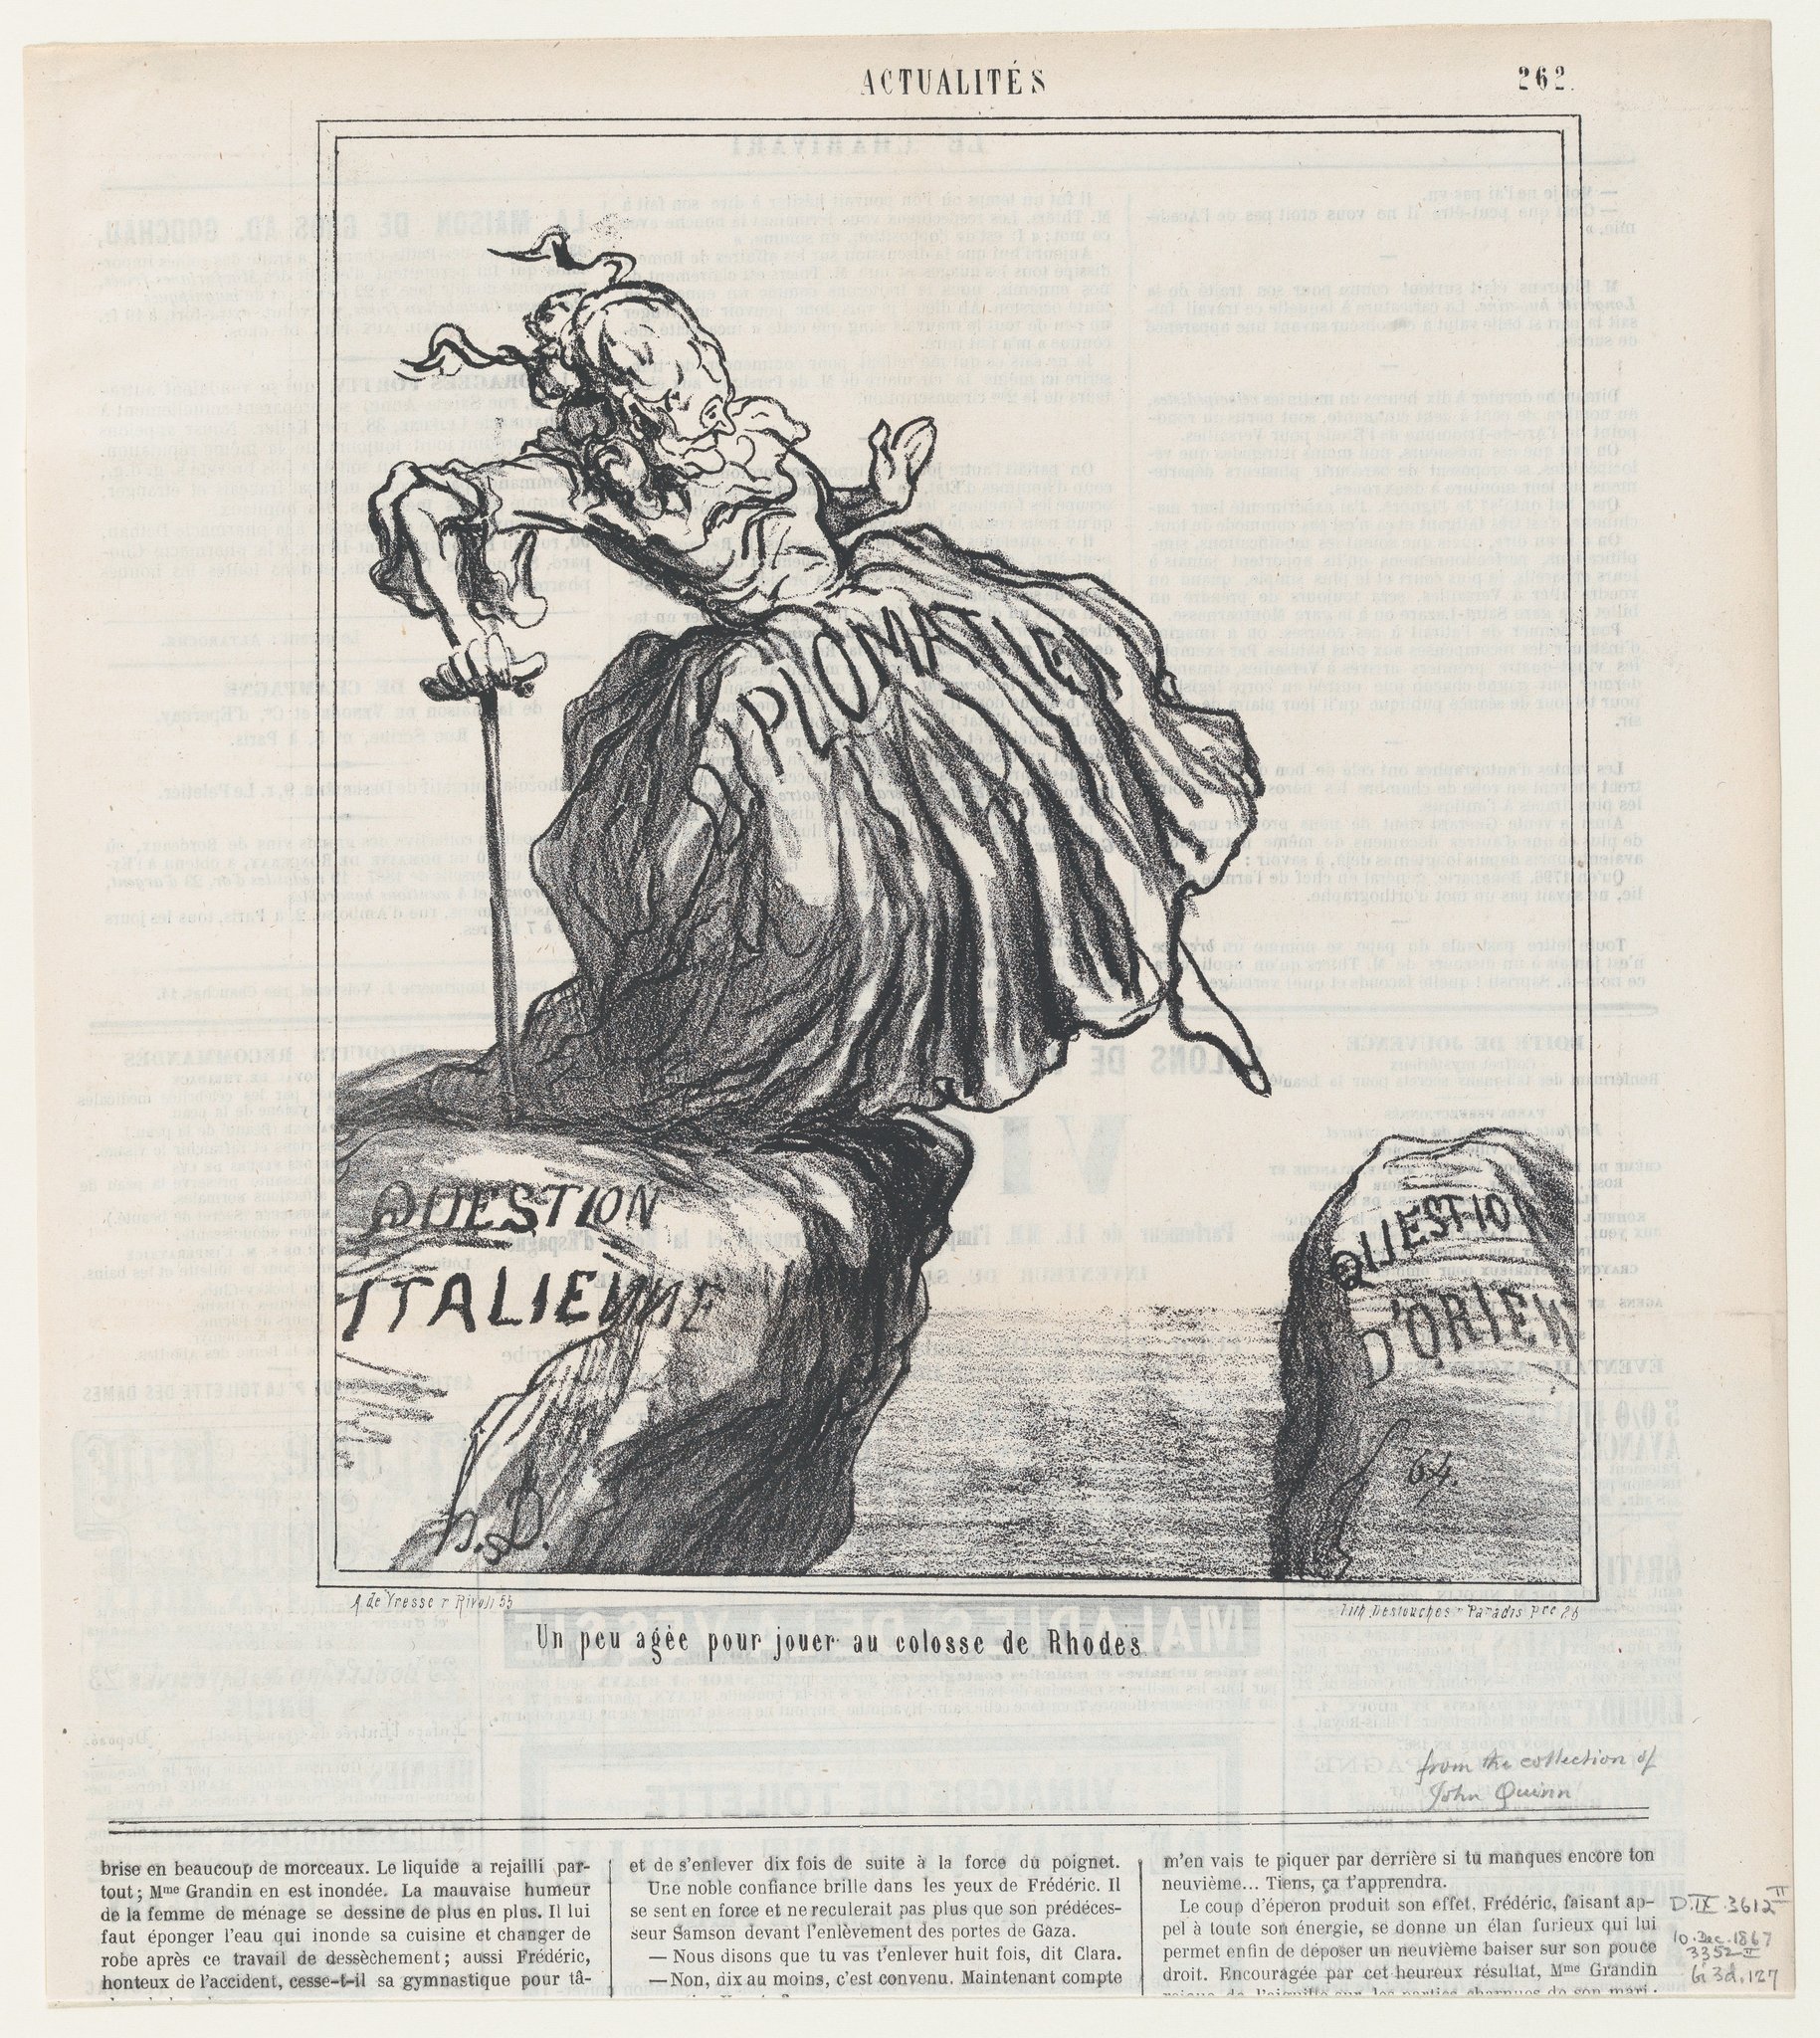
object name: print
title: A bit too old to play "Colossus of Rhodes," from 'News of the day,' published in Le Charivari, December 10, 1867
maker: honoré daumier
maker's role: artist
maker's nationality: french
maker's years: 1808-1879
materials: paper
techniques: lithograph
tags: satire,women